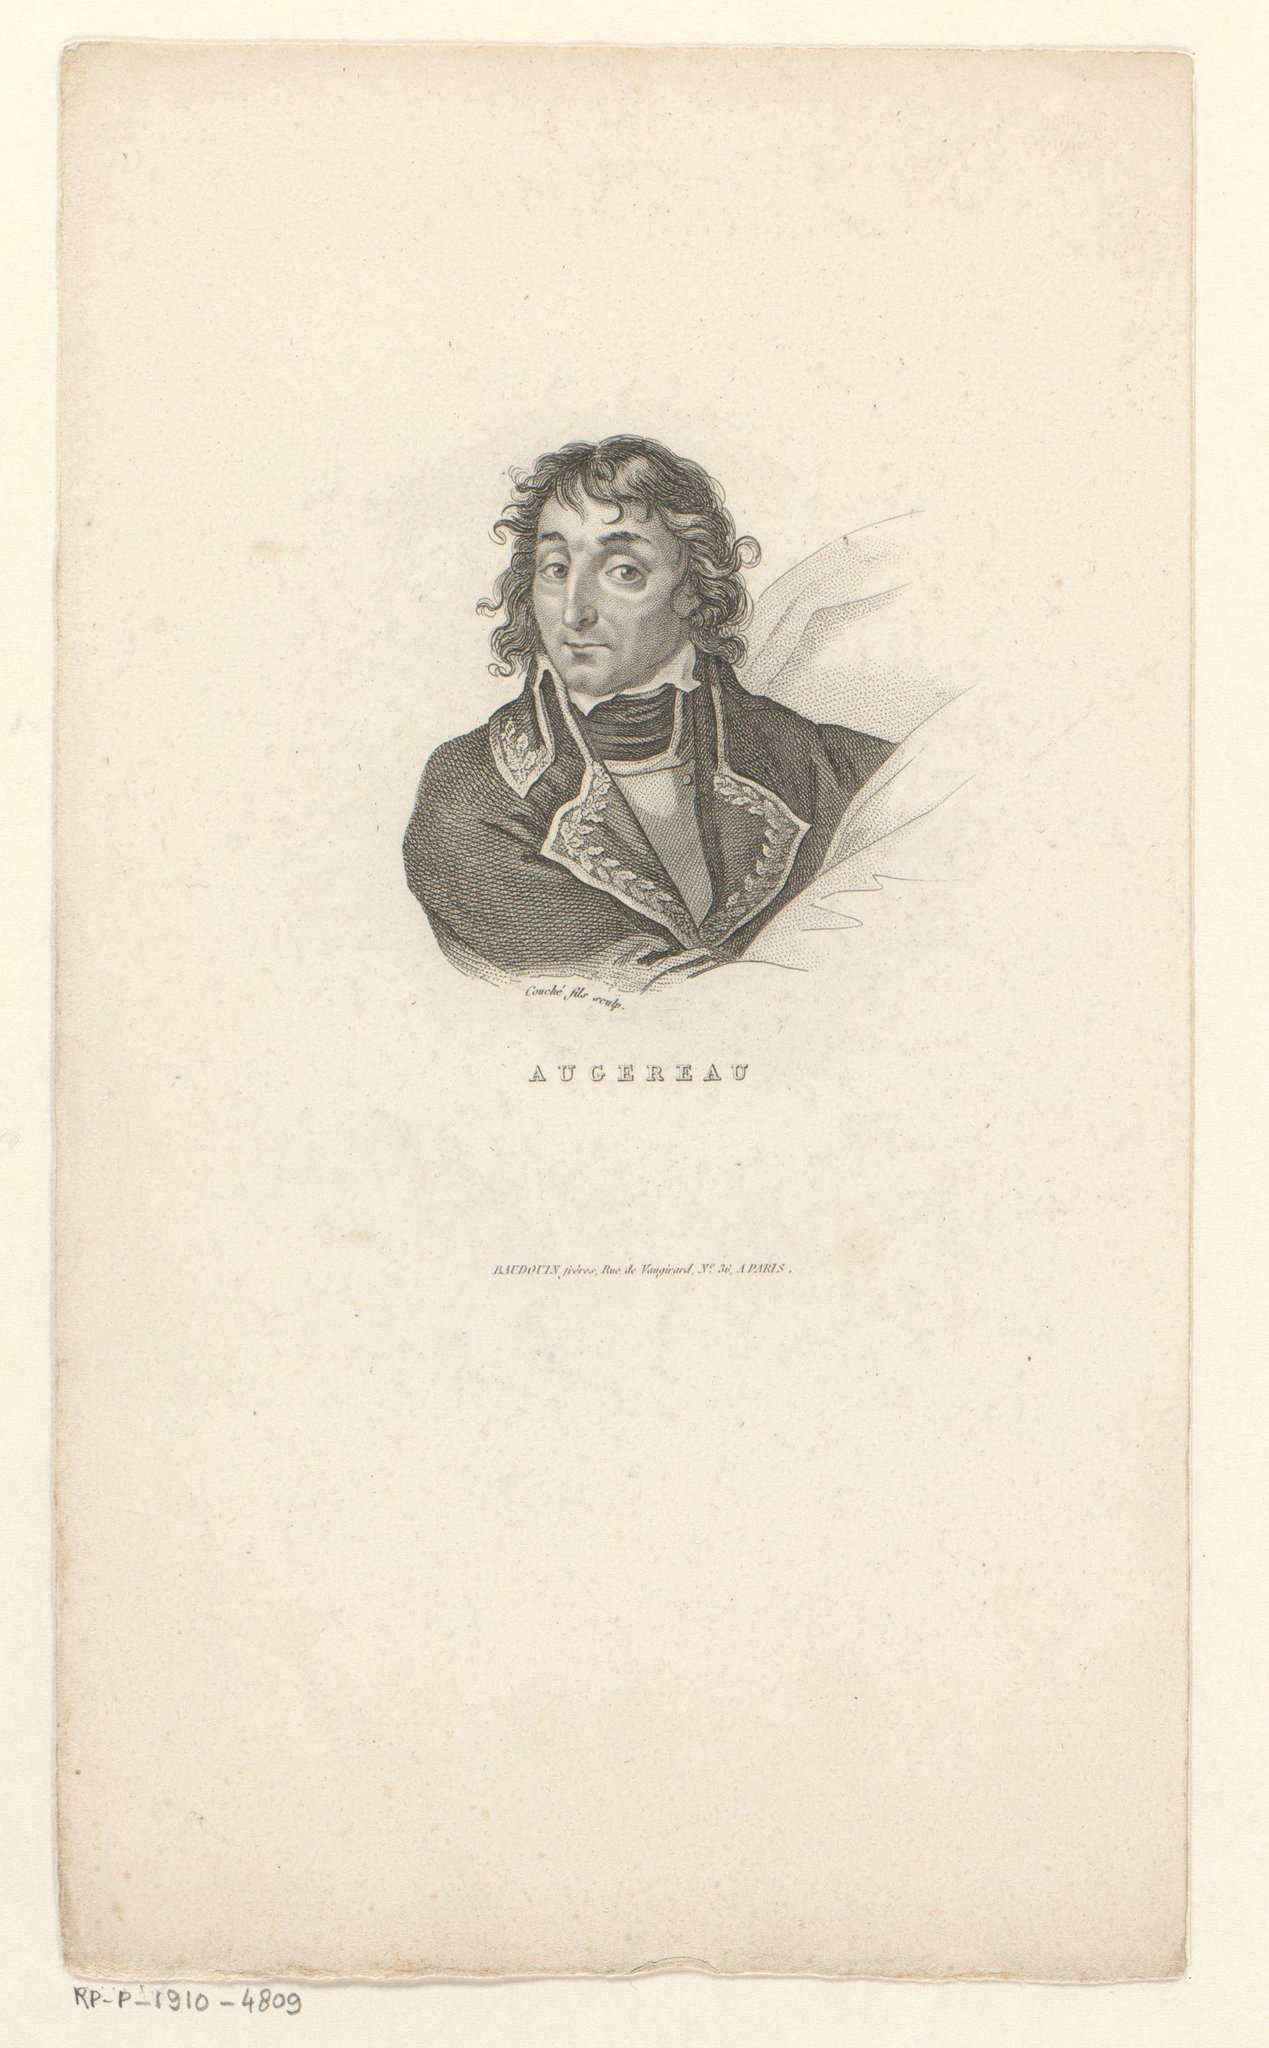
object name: print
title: Augereau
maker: françois louis couché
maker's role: print maker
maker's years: 1782-1849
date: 1816-1849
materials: paper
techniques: etching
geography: paris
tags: politician, historical persons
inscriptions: collector's mark: Lugt 2228